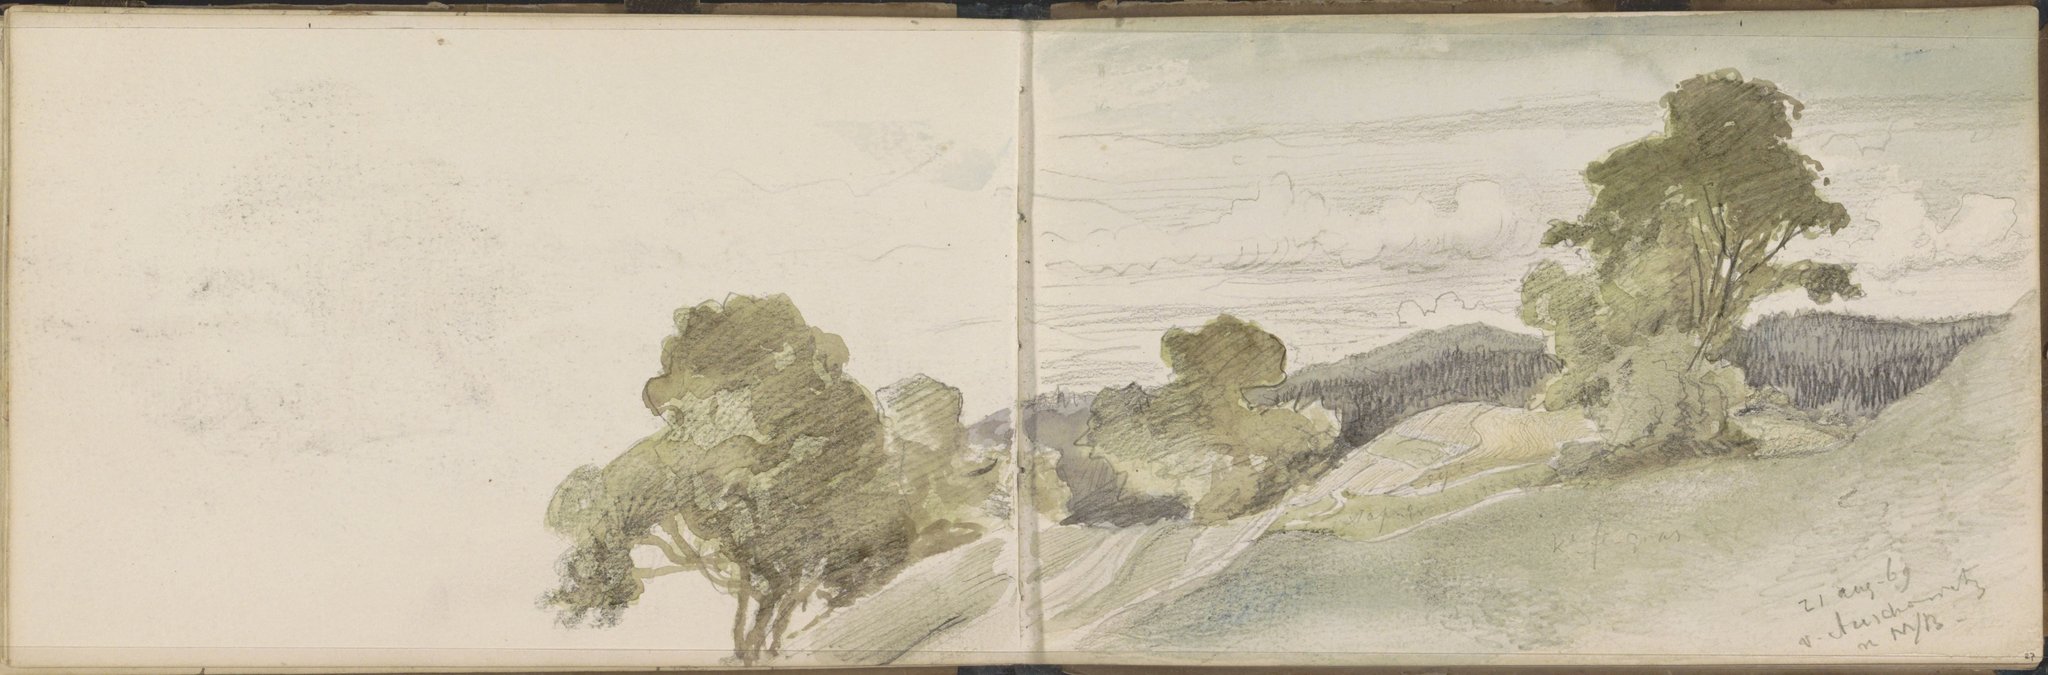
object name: sketchbook leaf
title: Berglandschap op de weg naar Marienbad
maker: johannes tavenraat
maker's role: draughtsman, painter, print maker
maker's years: 1809-1881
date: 1808-1869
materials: ink, paper, pencil, watercolor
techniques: brush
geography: marienbad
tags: landscapes, road, path, marienbad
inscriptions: date and inscription: ‘21 aug-69/ v/ Ausch[...]tz/ n M/B-’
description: Blad 26 verso en 27 recto uit een schetsboek met 48 bladen.